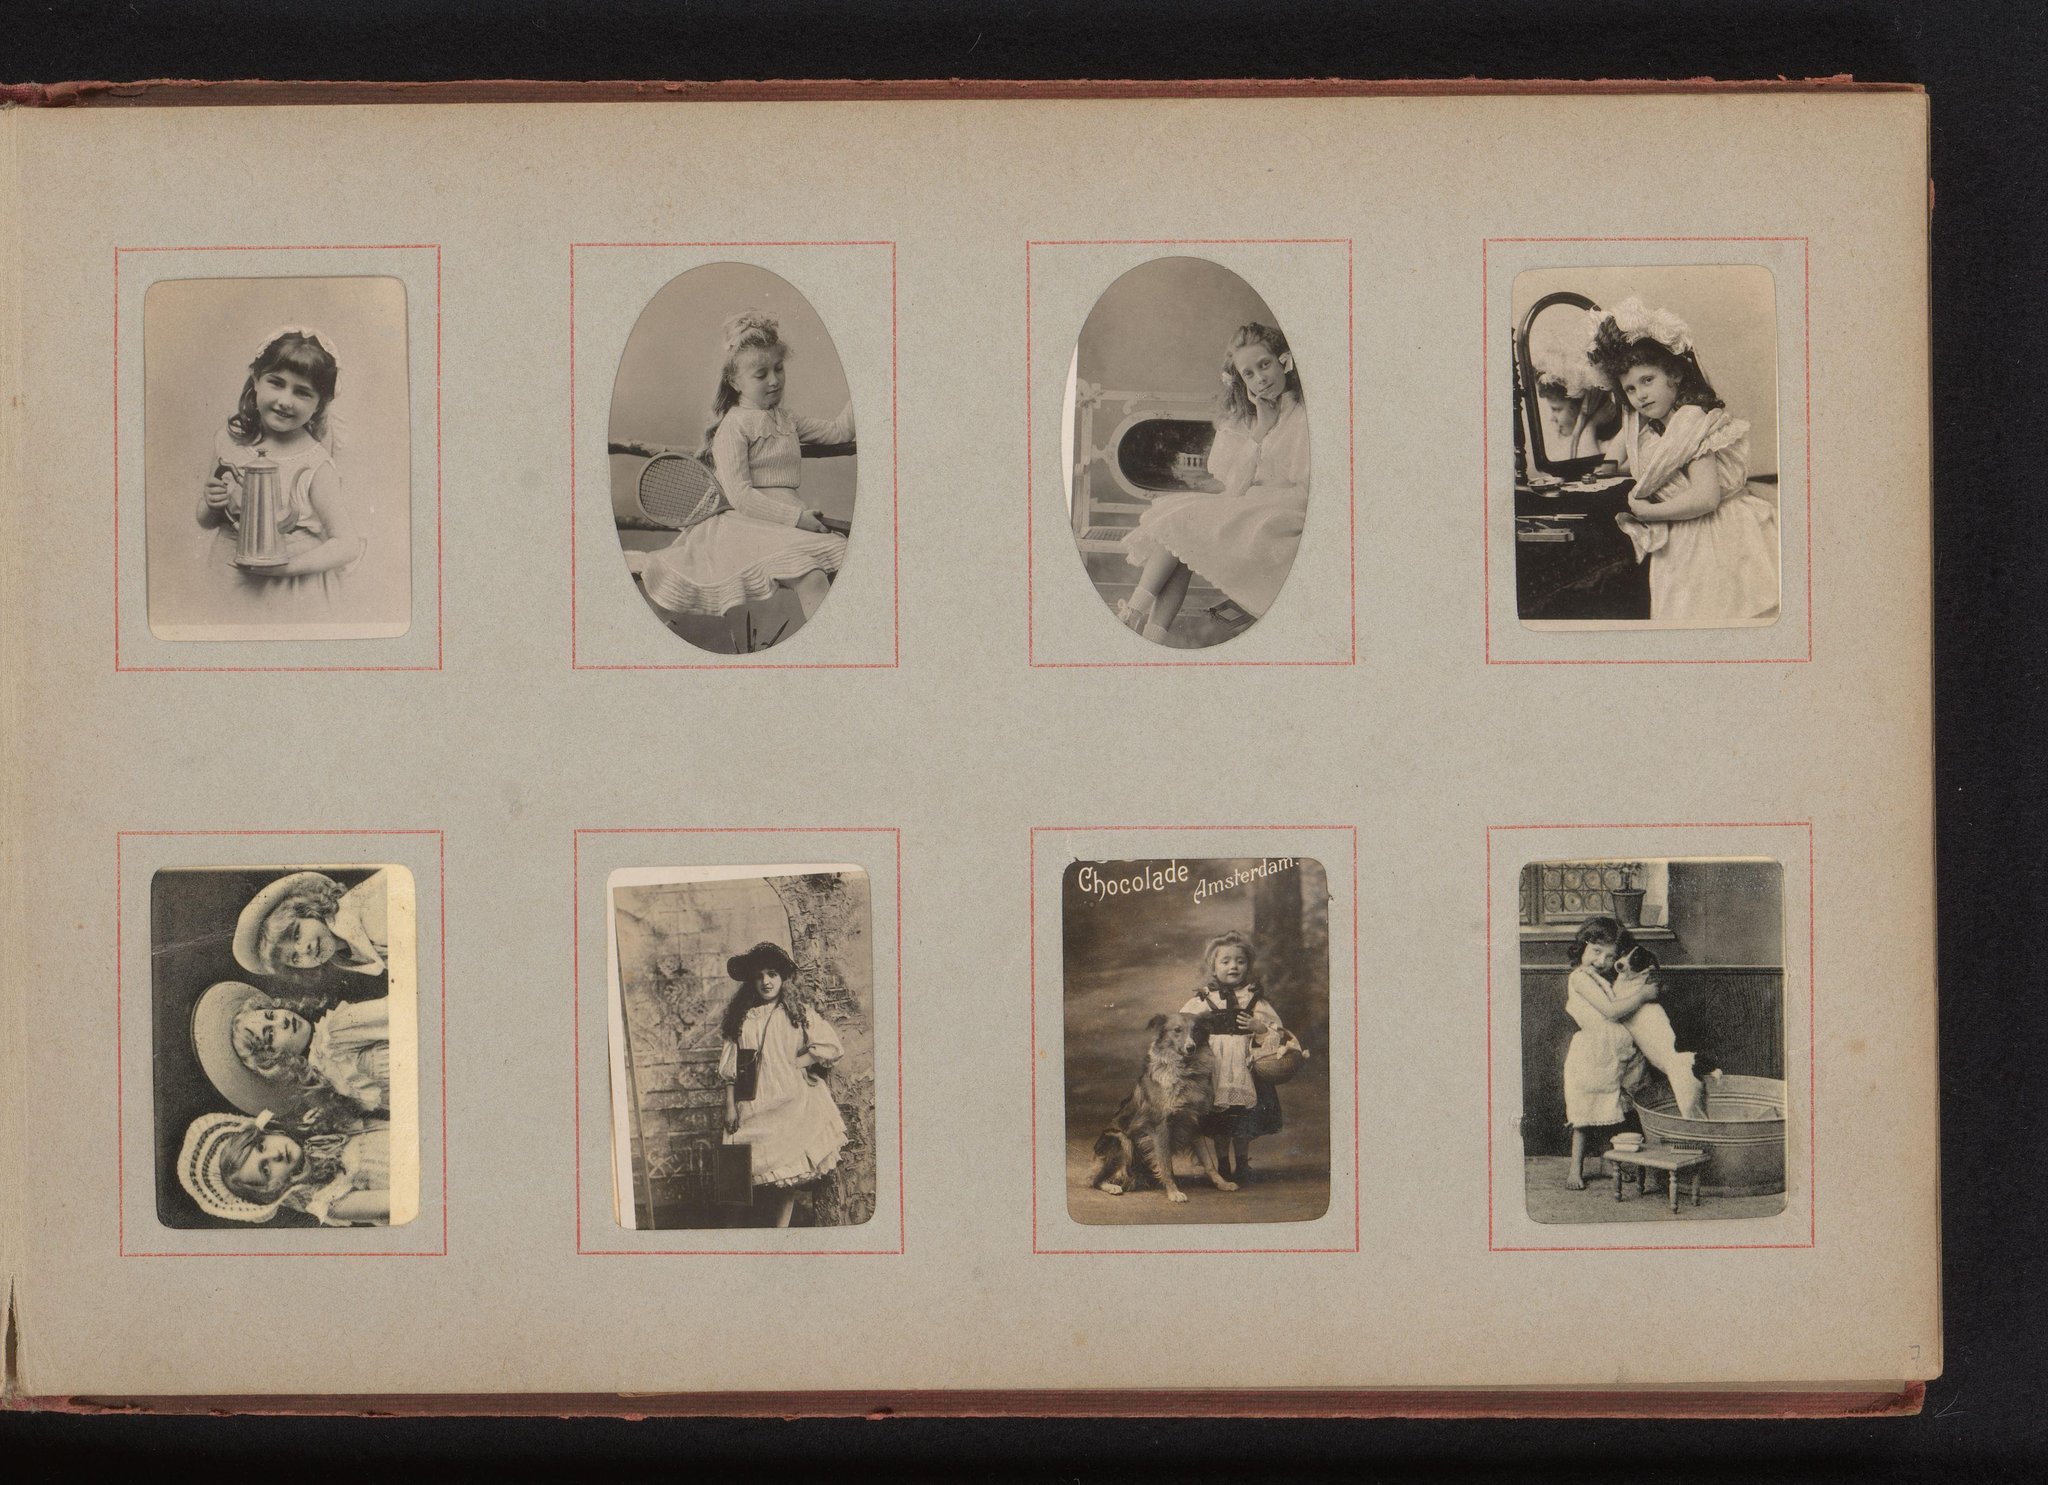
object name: photomechanical print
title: Kinderportretten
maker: Anonymous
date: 1890-1900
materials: cardboard, paper, photographic support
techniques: photograph, gelatin silver print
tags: girl (child between toddler and youth), dog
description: Acht portretten van kinderen, waaronder twee keer een meisje met hond. Deze pagina maakt deel uit van een album.